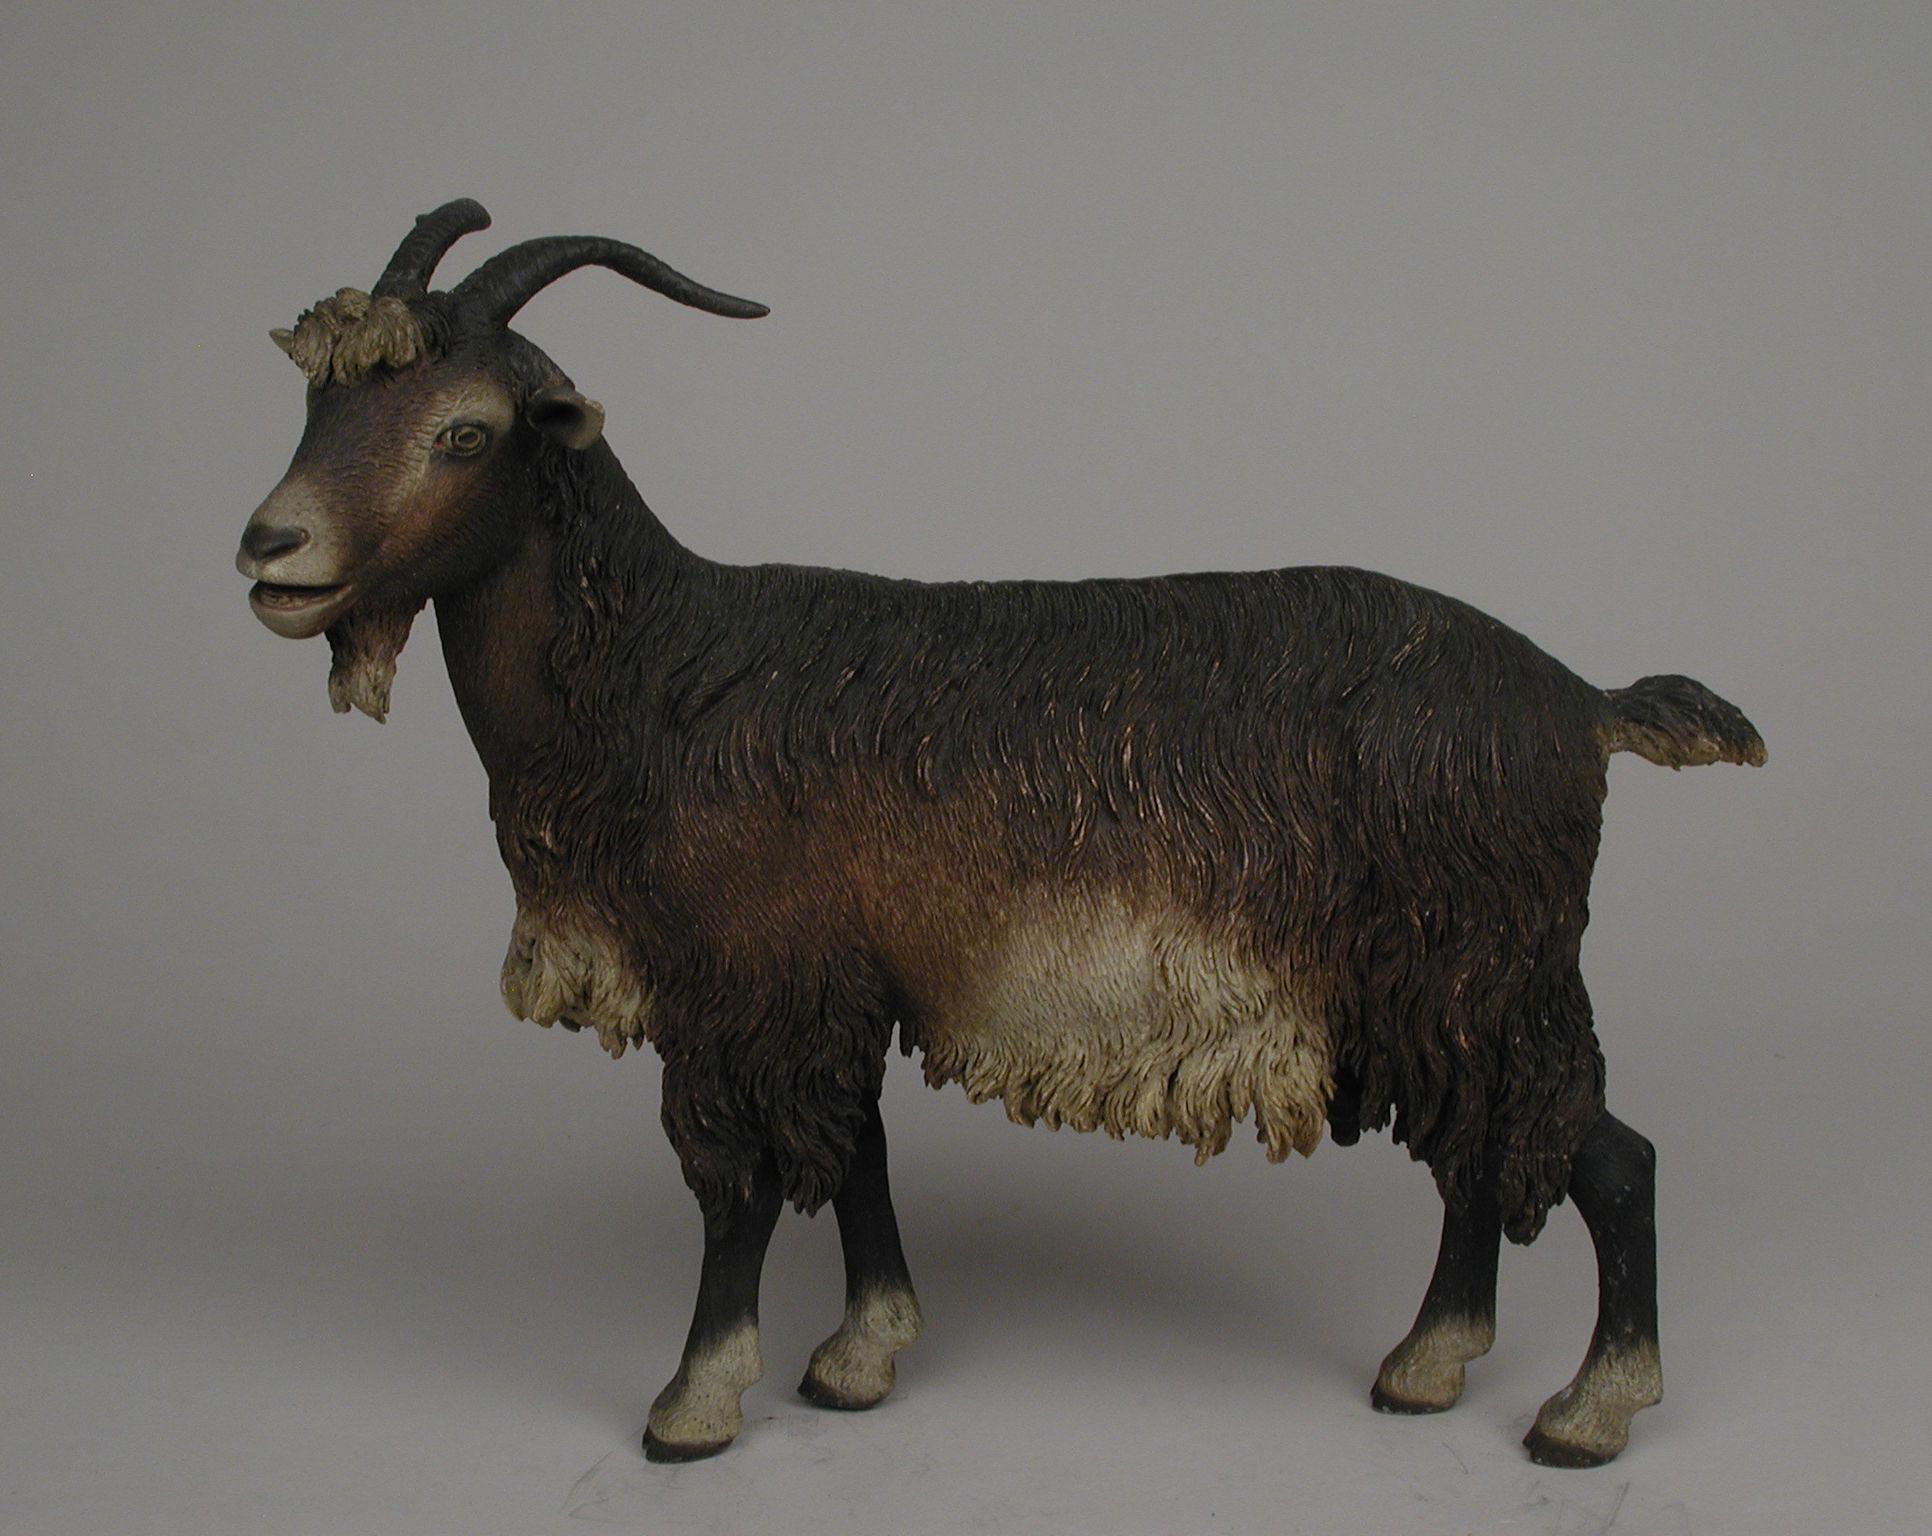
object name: crèche figure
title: Standing female goat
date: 1767-1833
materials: lead, terracotta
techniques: polychrome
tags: goats